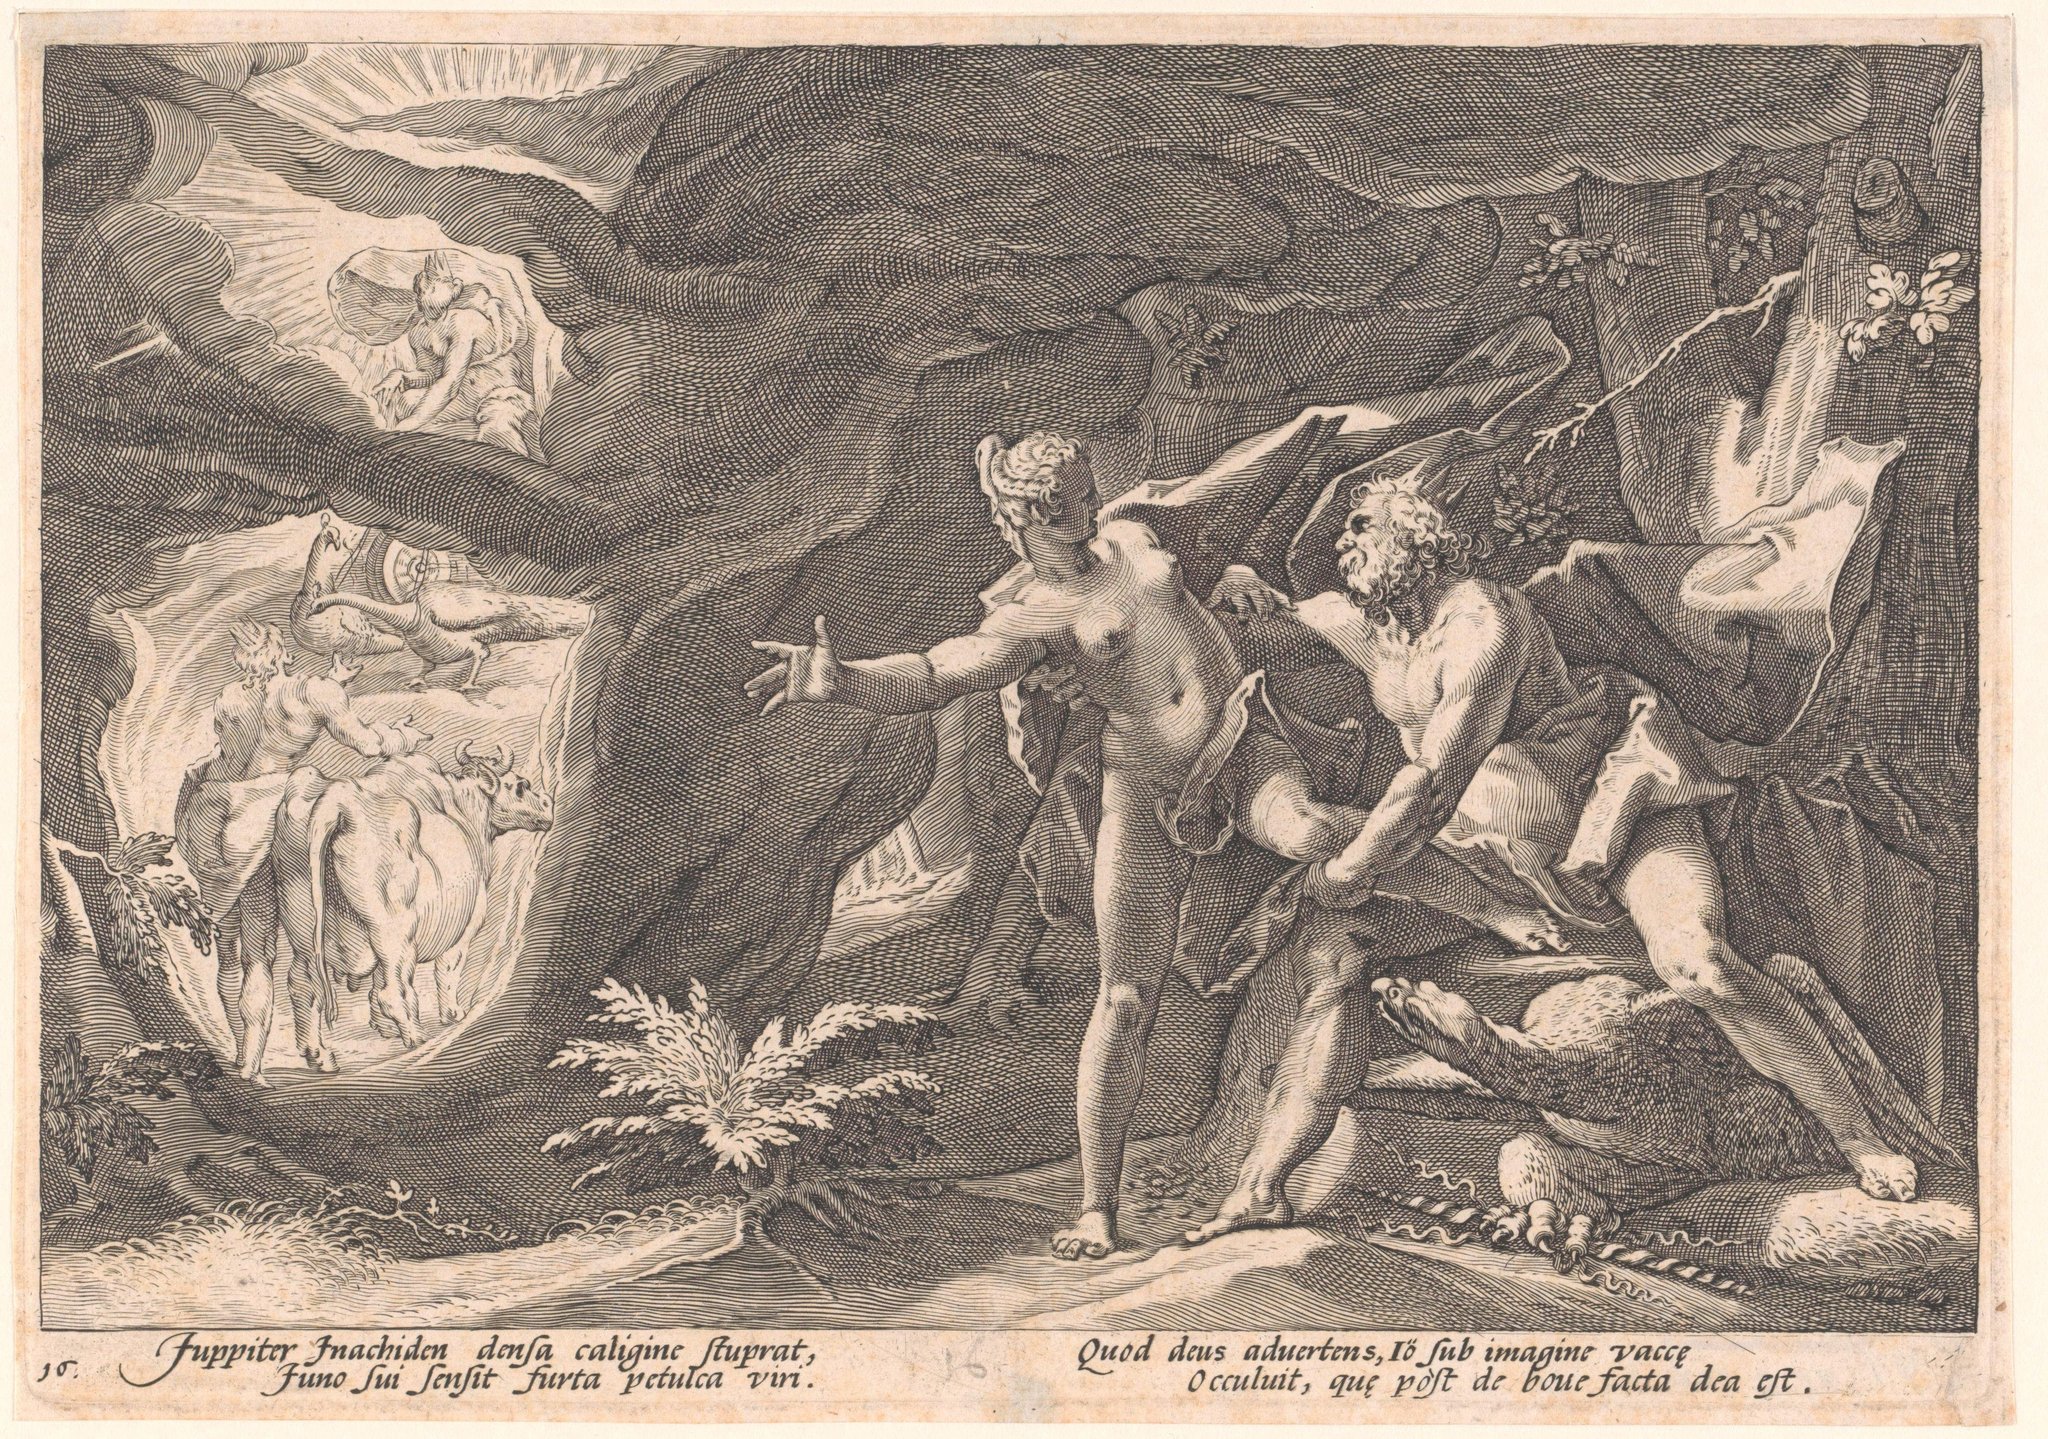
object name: print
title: Metamorfosen van Ovidius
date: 1589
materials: paper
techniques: engraving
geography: haarlem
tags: io changed into a cow: to avoid detection by juno, jupiter changes io into a cow (ovid, metamorphoses i 611)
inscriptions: collector's mark: ‘Hinloopen’, collector's mark: Lugt 11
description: Jupiter probeert Io te verleiden. Links op de achtergrond is Io in een koe veranderd door Jupiter. Zijn echtgenote Juno nadert het stel in haar wagen die door pauwen wordt getrokken en ondervraagt haar man over het dier. In de ondermarge een vierregelige toelichting, in twee kolommen, in het Latijn.